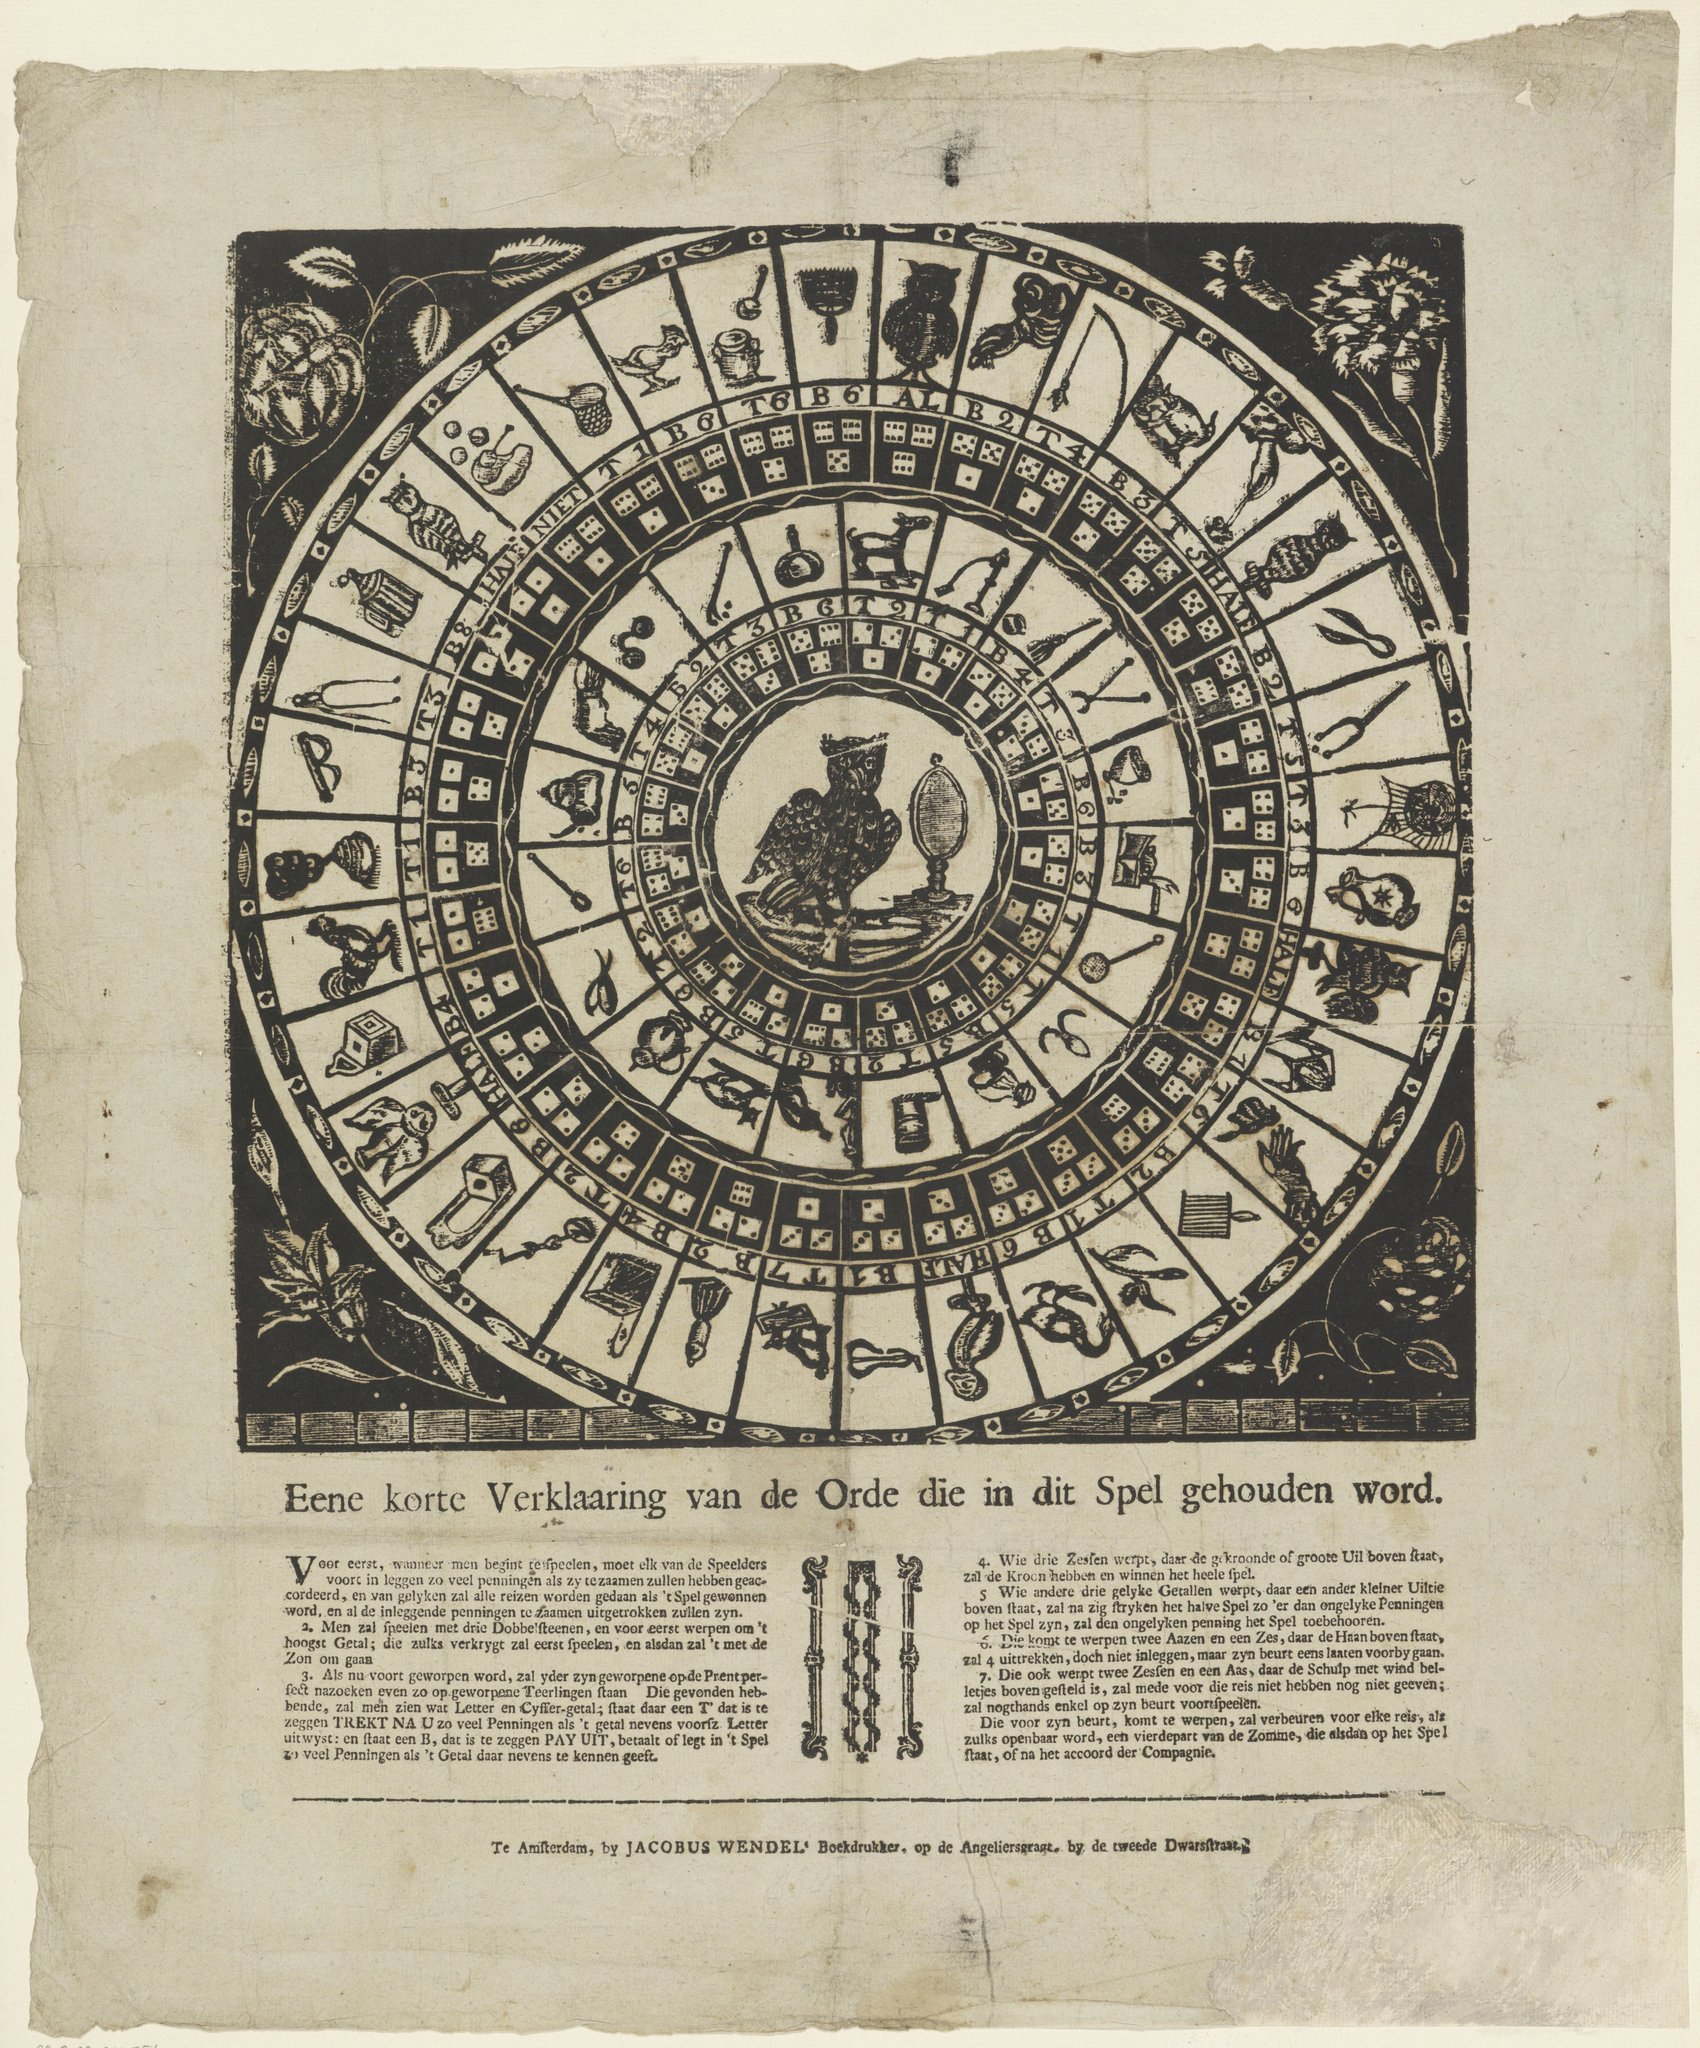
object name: print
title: Uilenspel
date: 1795-1819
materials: paper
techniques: letterpress printing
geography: amsterdam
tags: board-games of chance, owls, board-games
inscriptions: collector's mark: Lugt 2760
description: Het Uilenspel. Een cirkelvormig bordspel met vakjes met daarin voorwerpen, dieren en dobbelstenen. In het midden een uil met een spiegel. Onder de voorstelling de spelregels in twee kolommen.